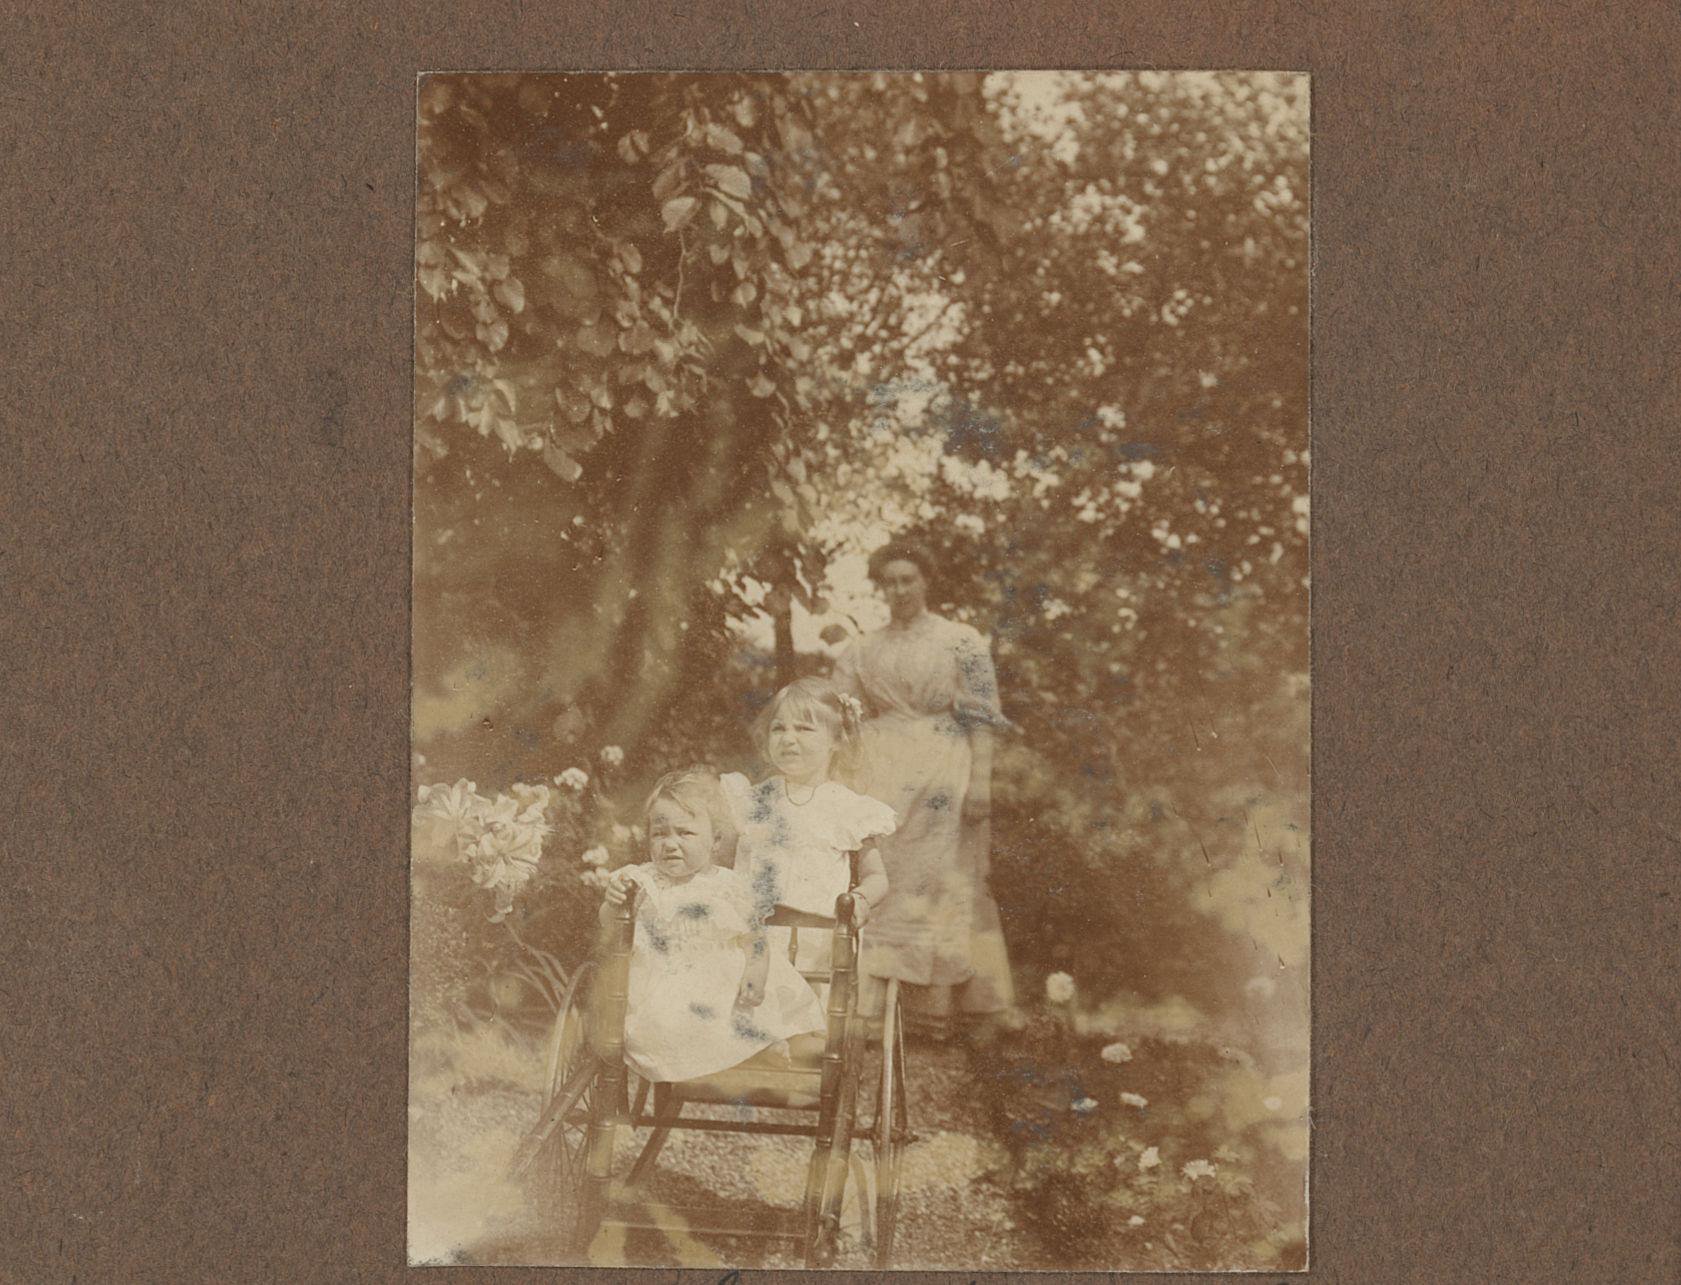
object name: photograph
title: Mevrouw Diepenbrock met dochters Joanna en Thea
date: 1908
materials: photographic support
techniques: photography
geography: amsterdam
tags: amsterdam, jonkvrouw wilhelmina elisabeth petronella cornelia de jong van beek en donk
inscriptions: date: ‘10 Augustus 1908’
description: Foto op bruin albumblad 12 van familiealbum van Alphons Diepenbrock.